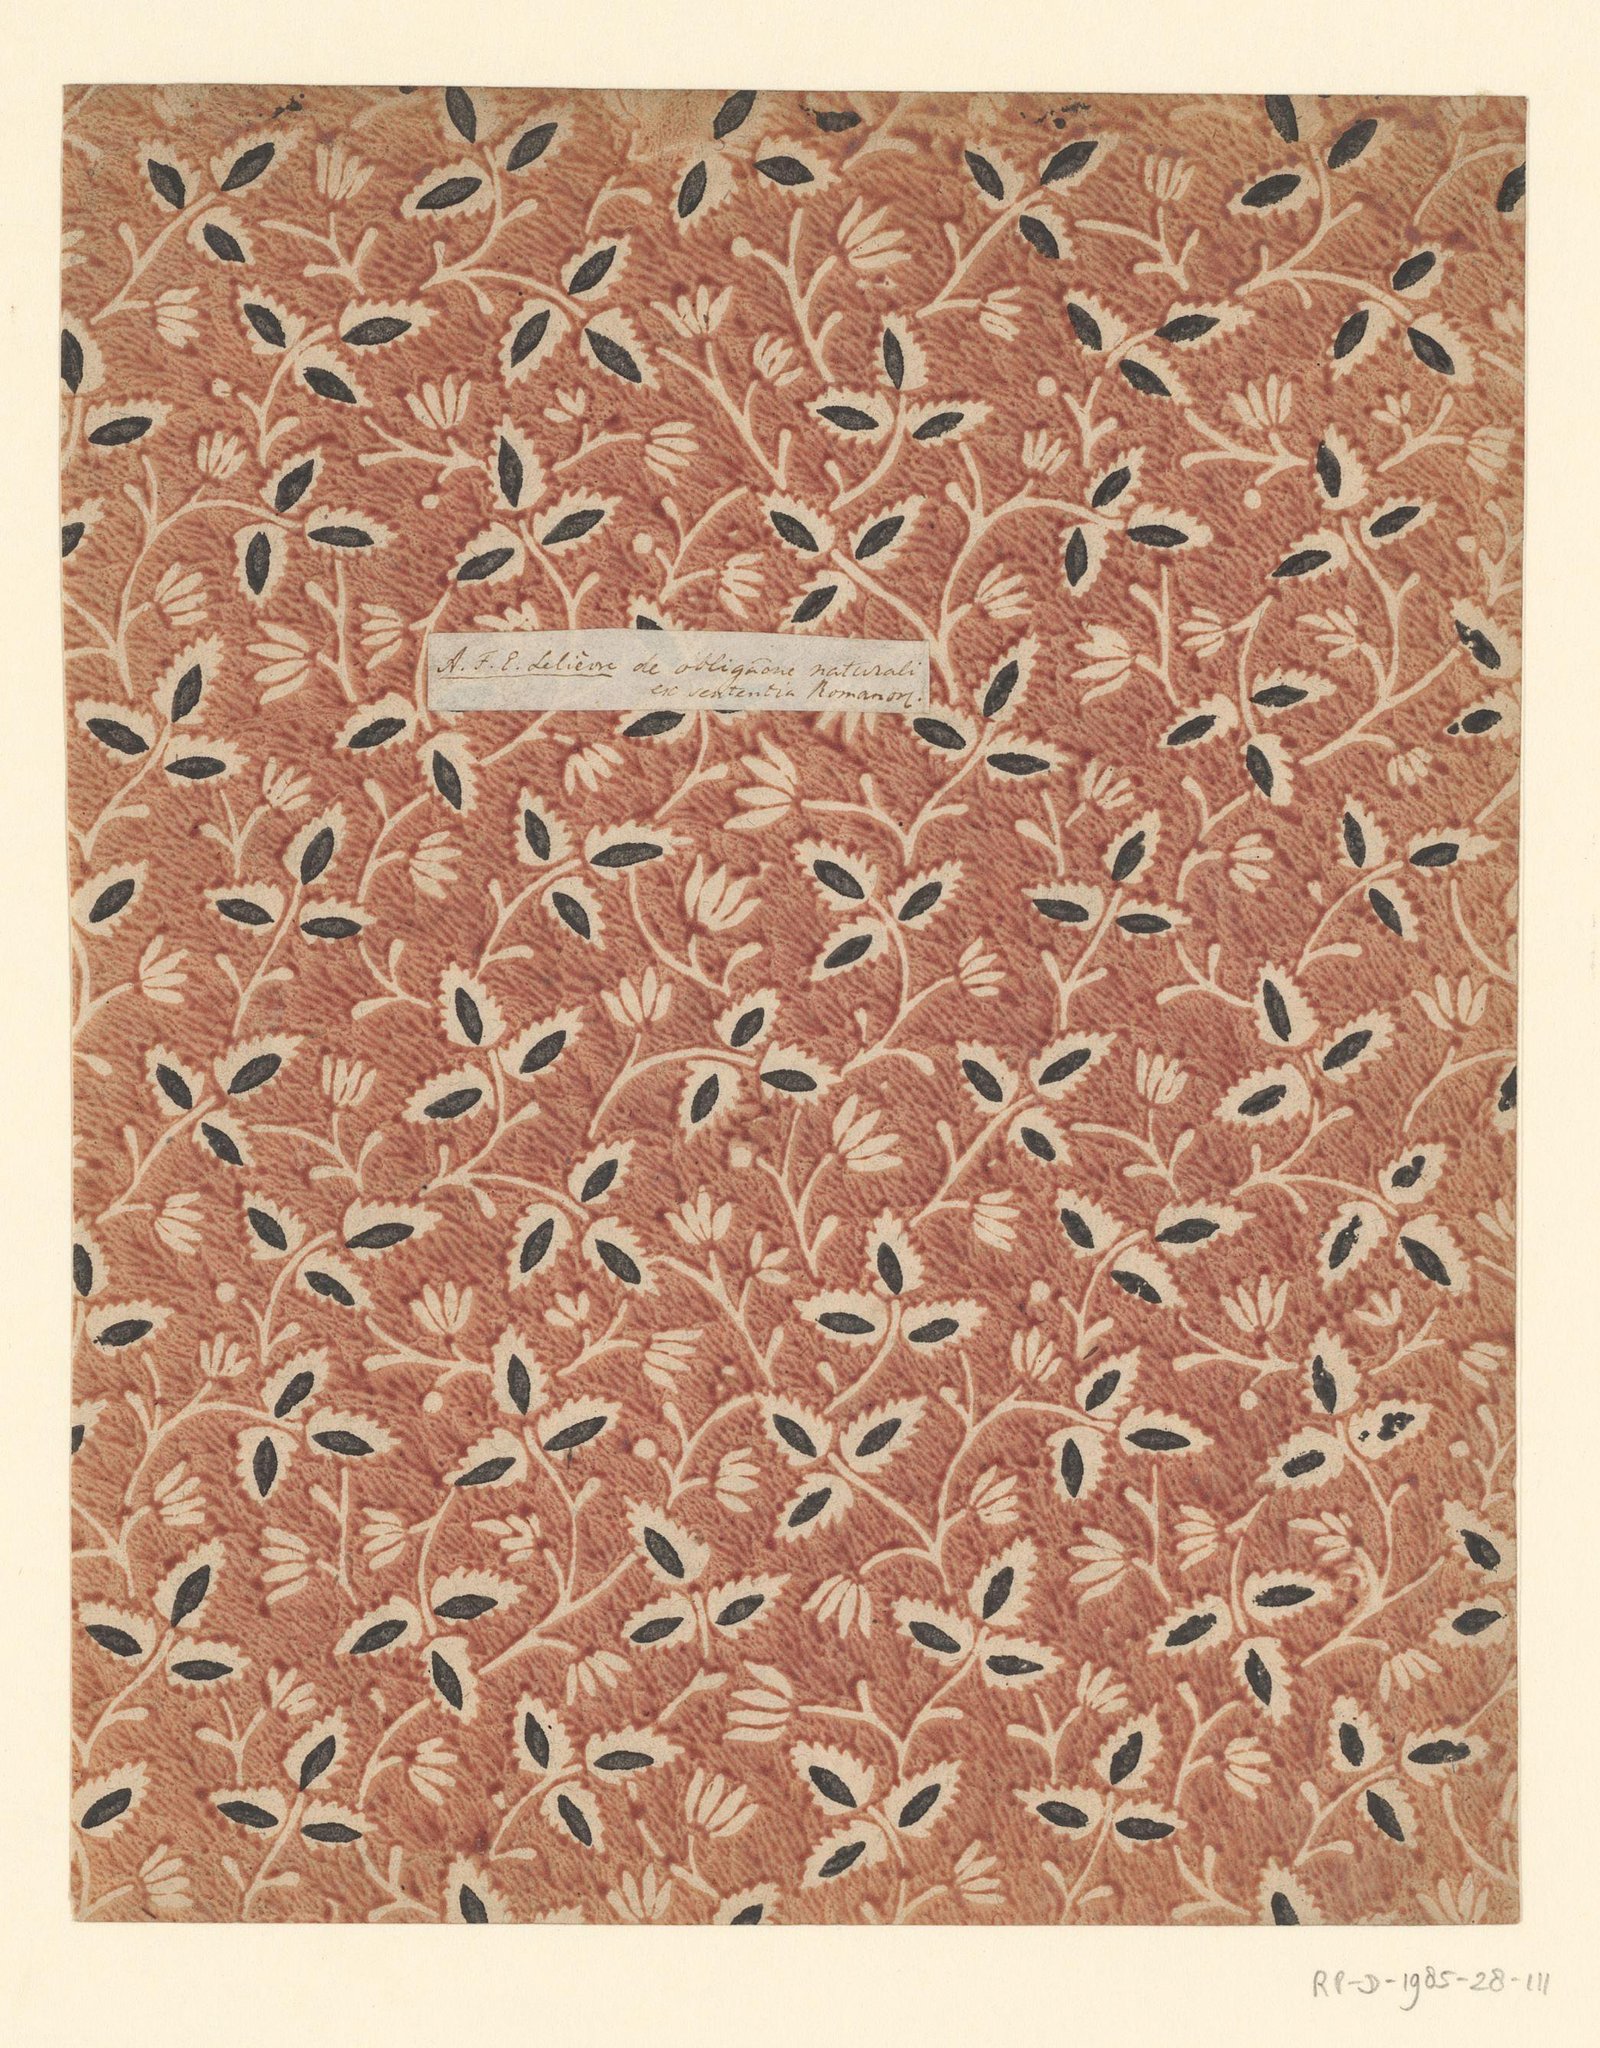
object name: printed paper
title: Blad met strooipatroon van uitgespaard takje met blad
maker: Anonymous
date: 1750-1900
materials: paper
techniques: printing block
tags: ornament derived from plant forms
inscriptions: collector's mark: Lugt 2760, collector's mark: Lugt 2228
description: Blad met strooipatroon van uitgespaard takje met blad. Met etiket met opschrift: 'A.F.E. Lelièvre ... Romanon'. Helft van een etiket.